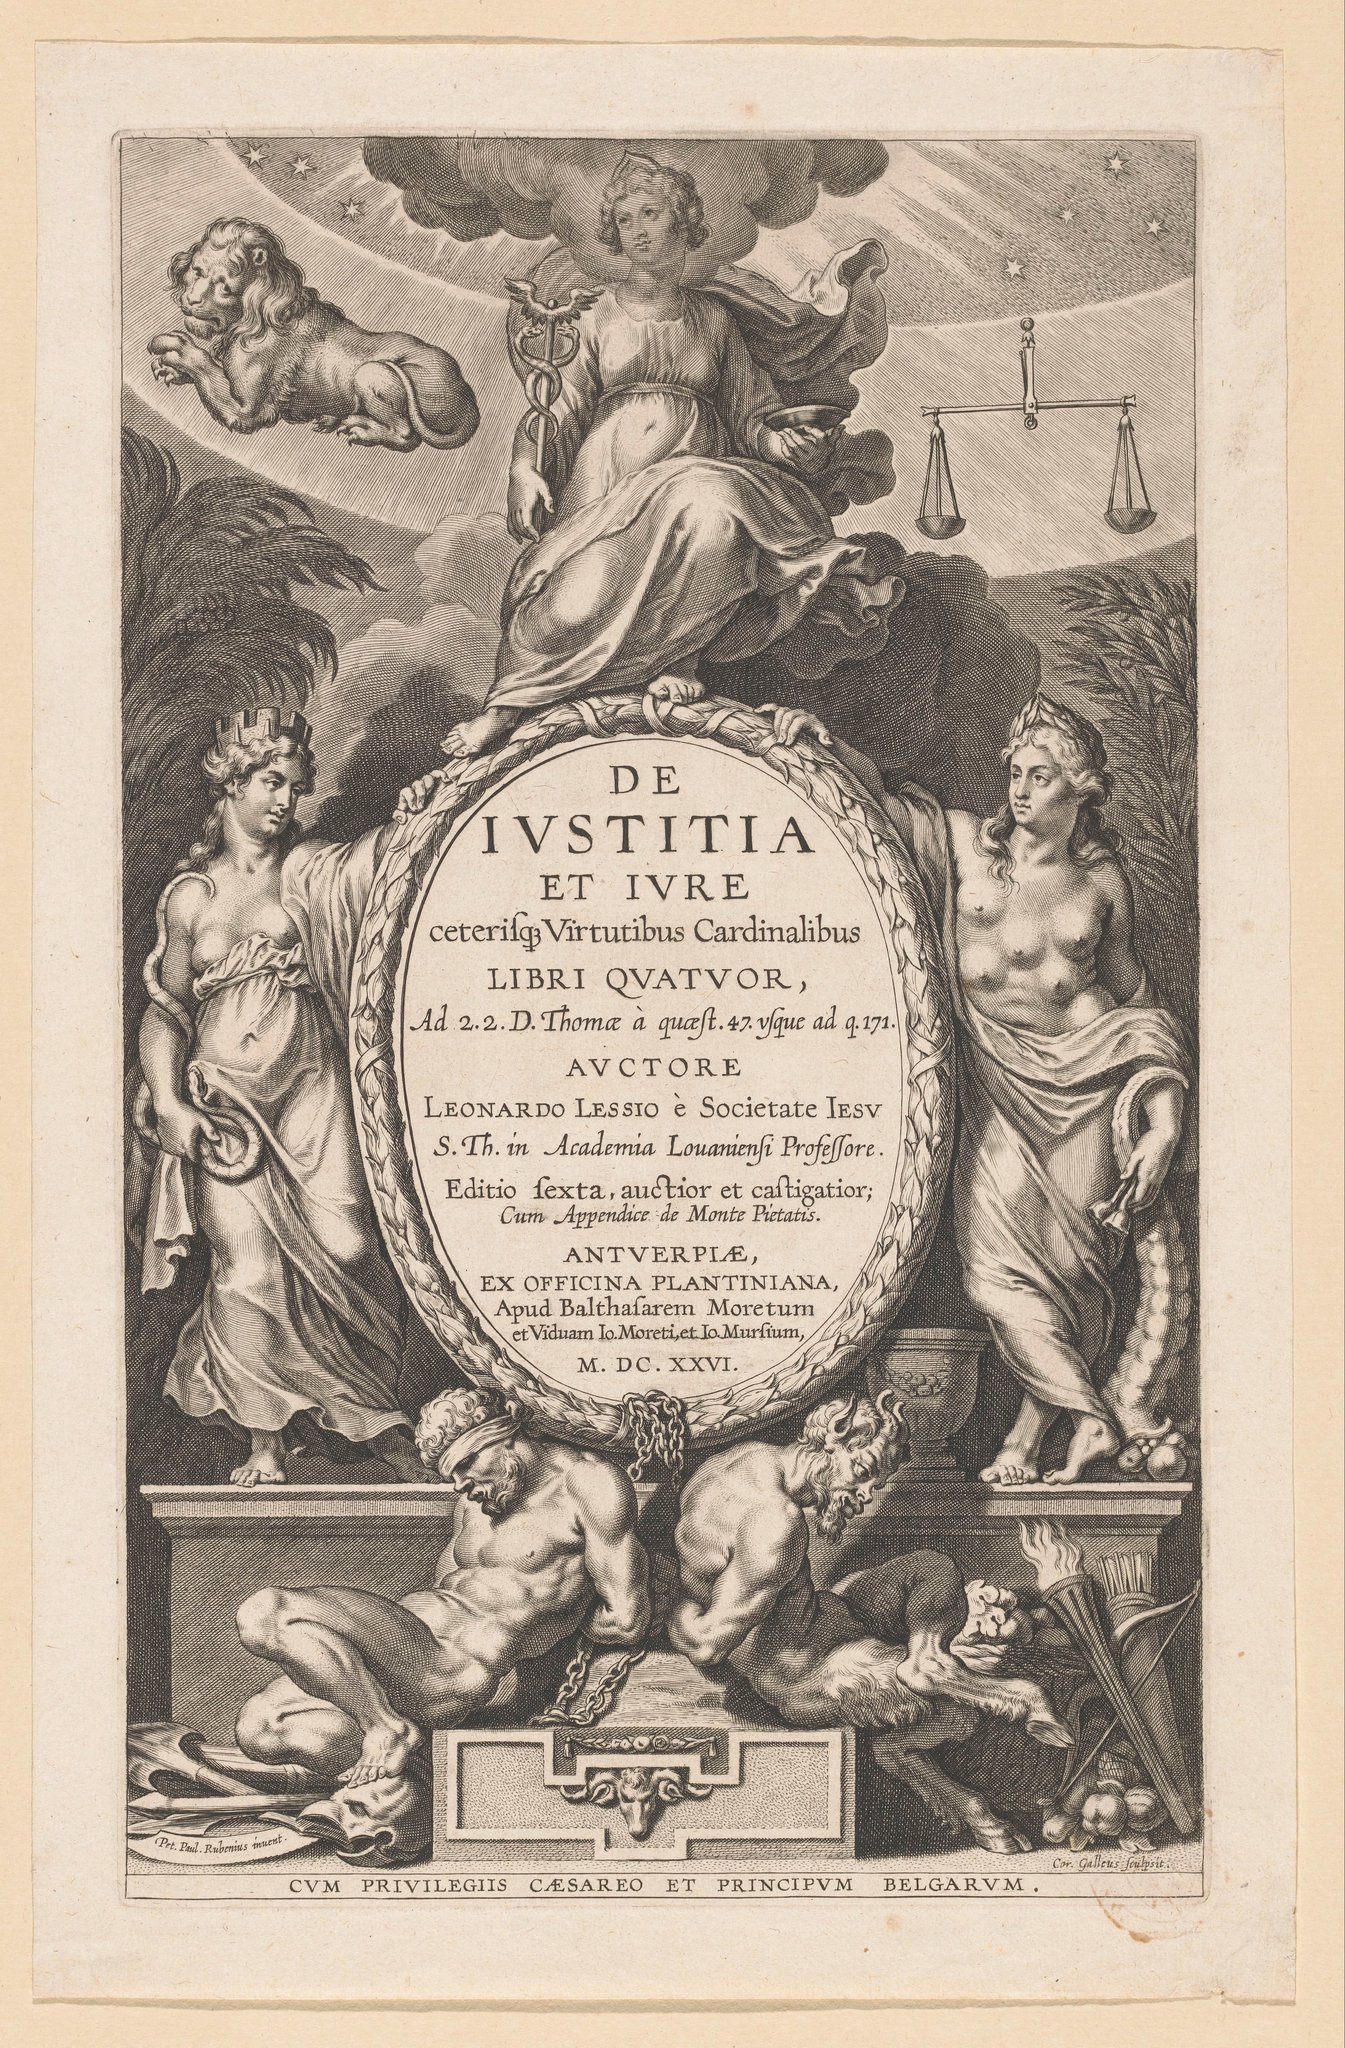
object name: print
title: Titelpagina voor: L. Lessius, De justitia et jure, Antwerpen: 1626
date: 1626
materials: paper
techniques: engraving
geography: antwerp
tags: (story of) dike (astraea), goddess of righteousness and justice, allegory, personification of good government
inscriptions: collector's mark: Lugt 240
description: Tronende Astraea met caduceus en kommetje in haar handen. Aan weerszijden van haar de sterrenbeelden leeuw en weegschaal. Links de personificatie van goed bestuur, met stedenkroon en slang. Rechts een vrouw met vijf borsten en een hoorn des overvloeds. Aan en sokkel zijn een man en een duivel geketend.